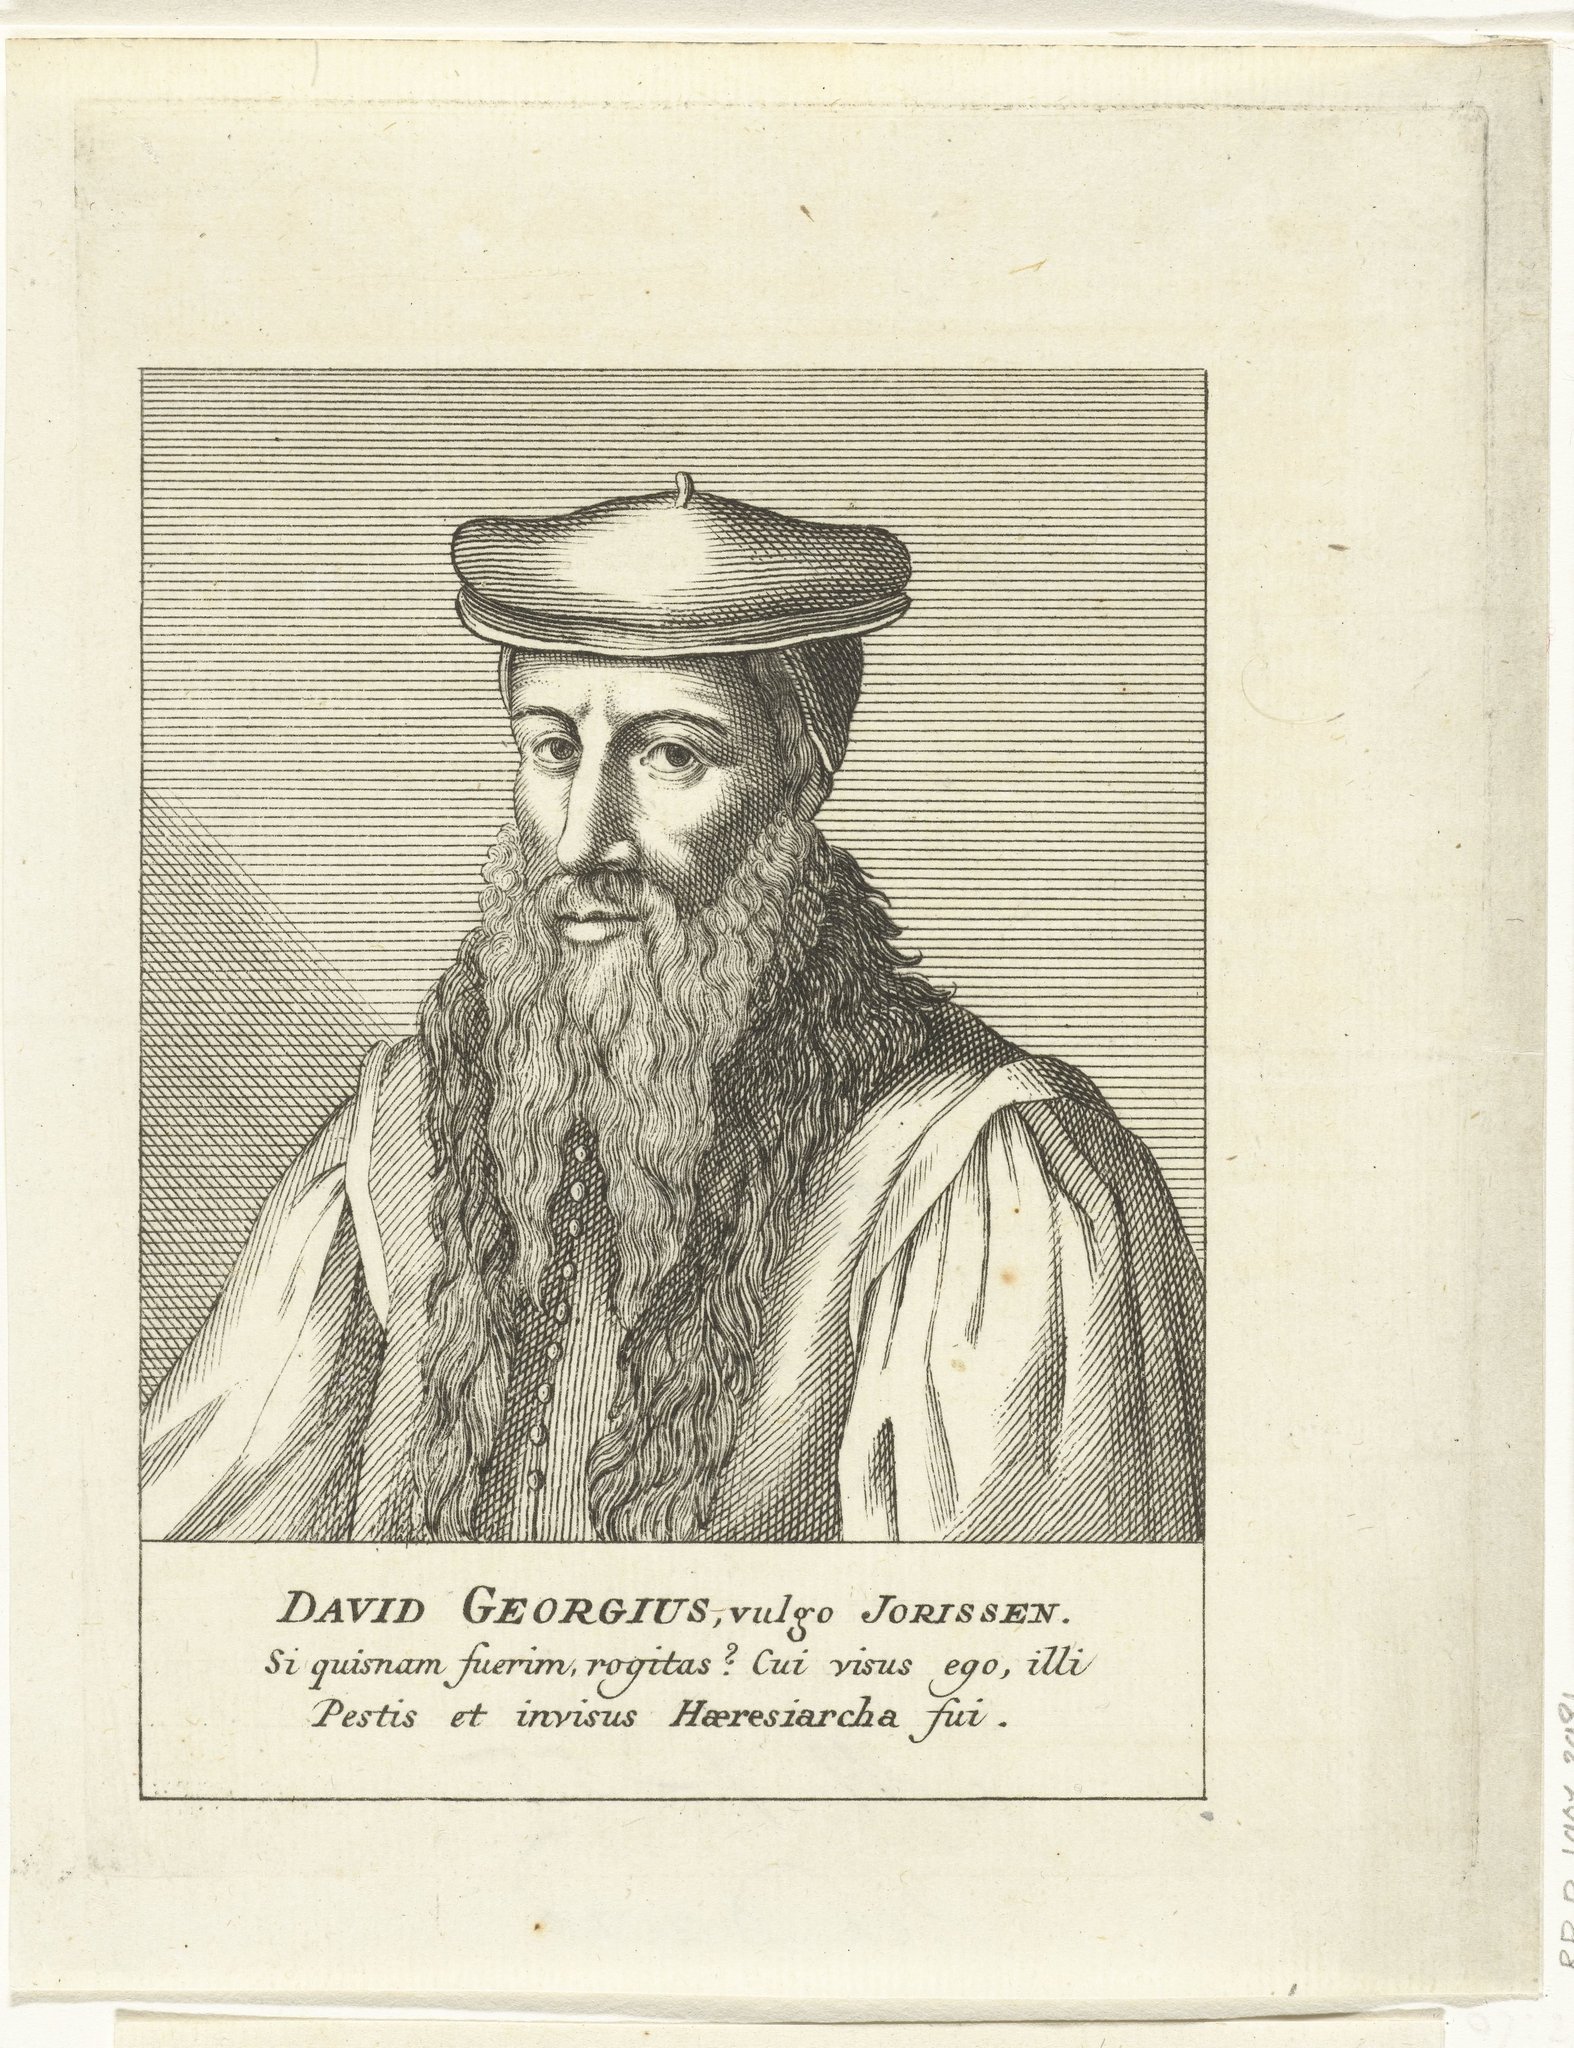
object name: print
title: Portret van geleerde David Jorissen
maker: françois van bleyswijck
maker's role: draughtsman, print maker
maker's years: 1671-1746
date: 1681-1746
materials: paper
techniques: engraving, etching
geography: leiden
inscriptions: collector's mark: Lugt 2228